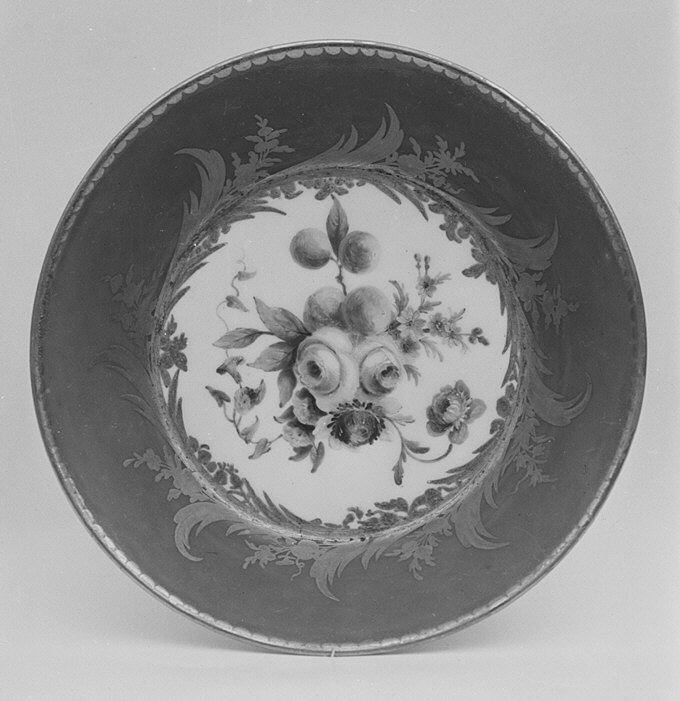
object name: saucer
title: Saucer (one of nine) (part of a service)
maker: sèvres manufactory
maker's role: manufactory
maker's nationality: french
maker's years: 1740-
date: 1787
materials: soft paste porcelain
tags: flowers